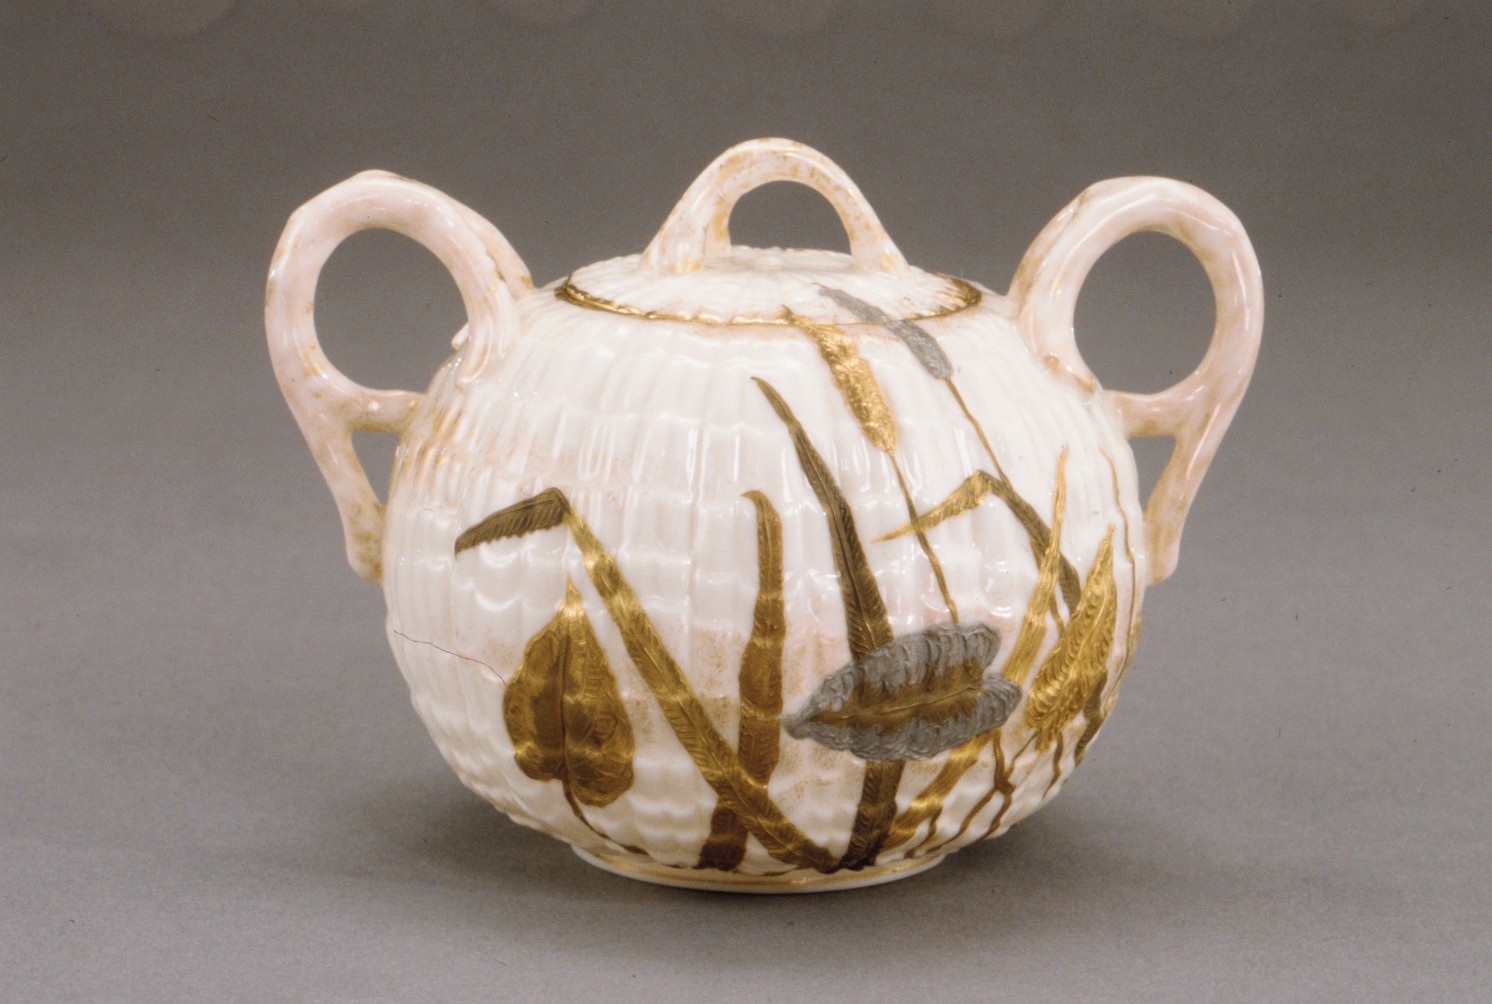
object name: sugar bowl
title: Covered Sugar Bowl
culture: american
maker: ott and brewer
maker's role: maker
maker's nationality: american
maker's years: 1871-1893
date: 1876-1883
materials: porcelain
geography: united states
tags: plants